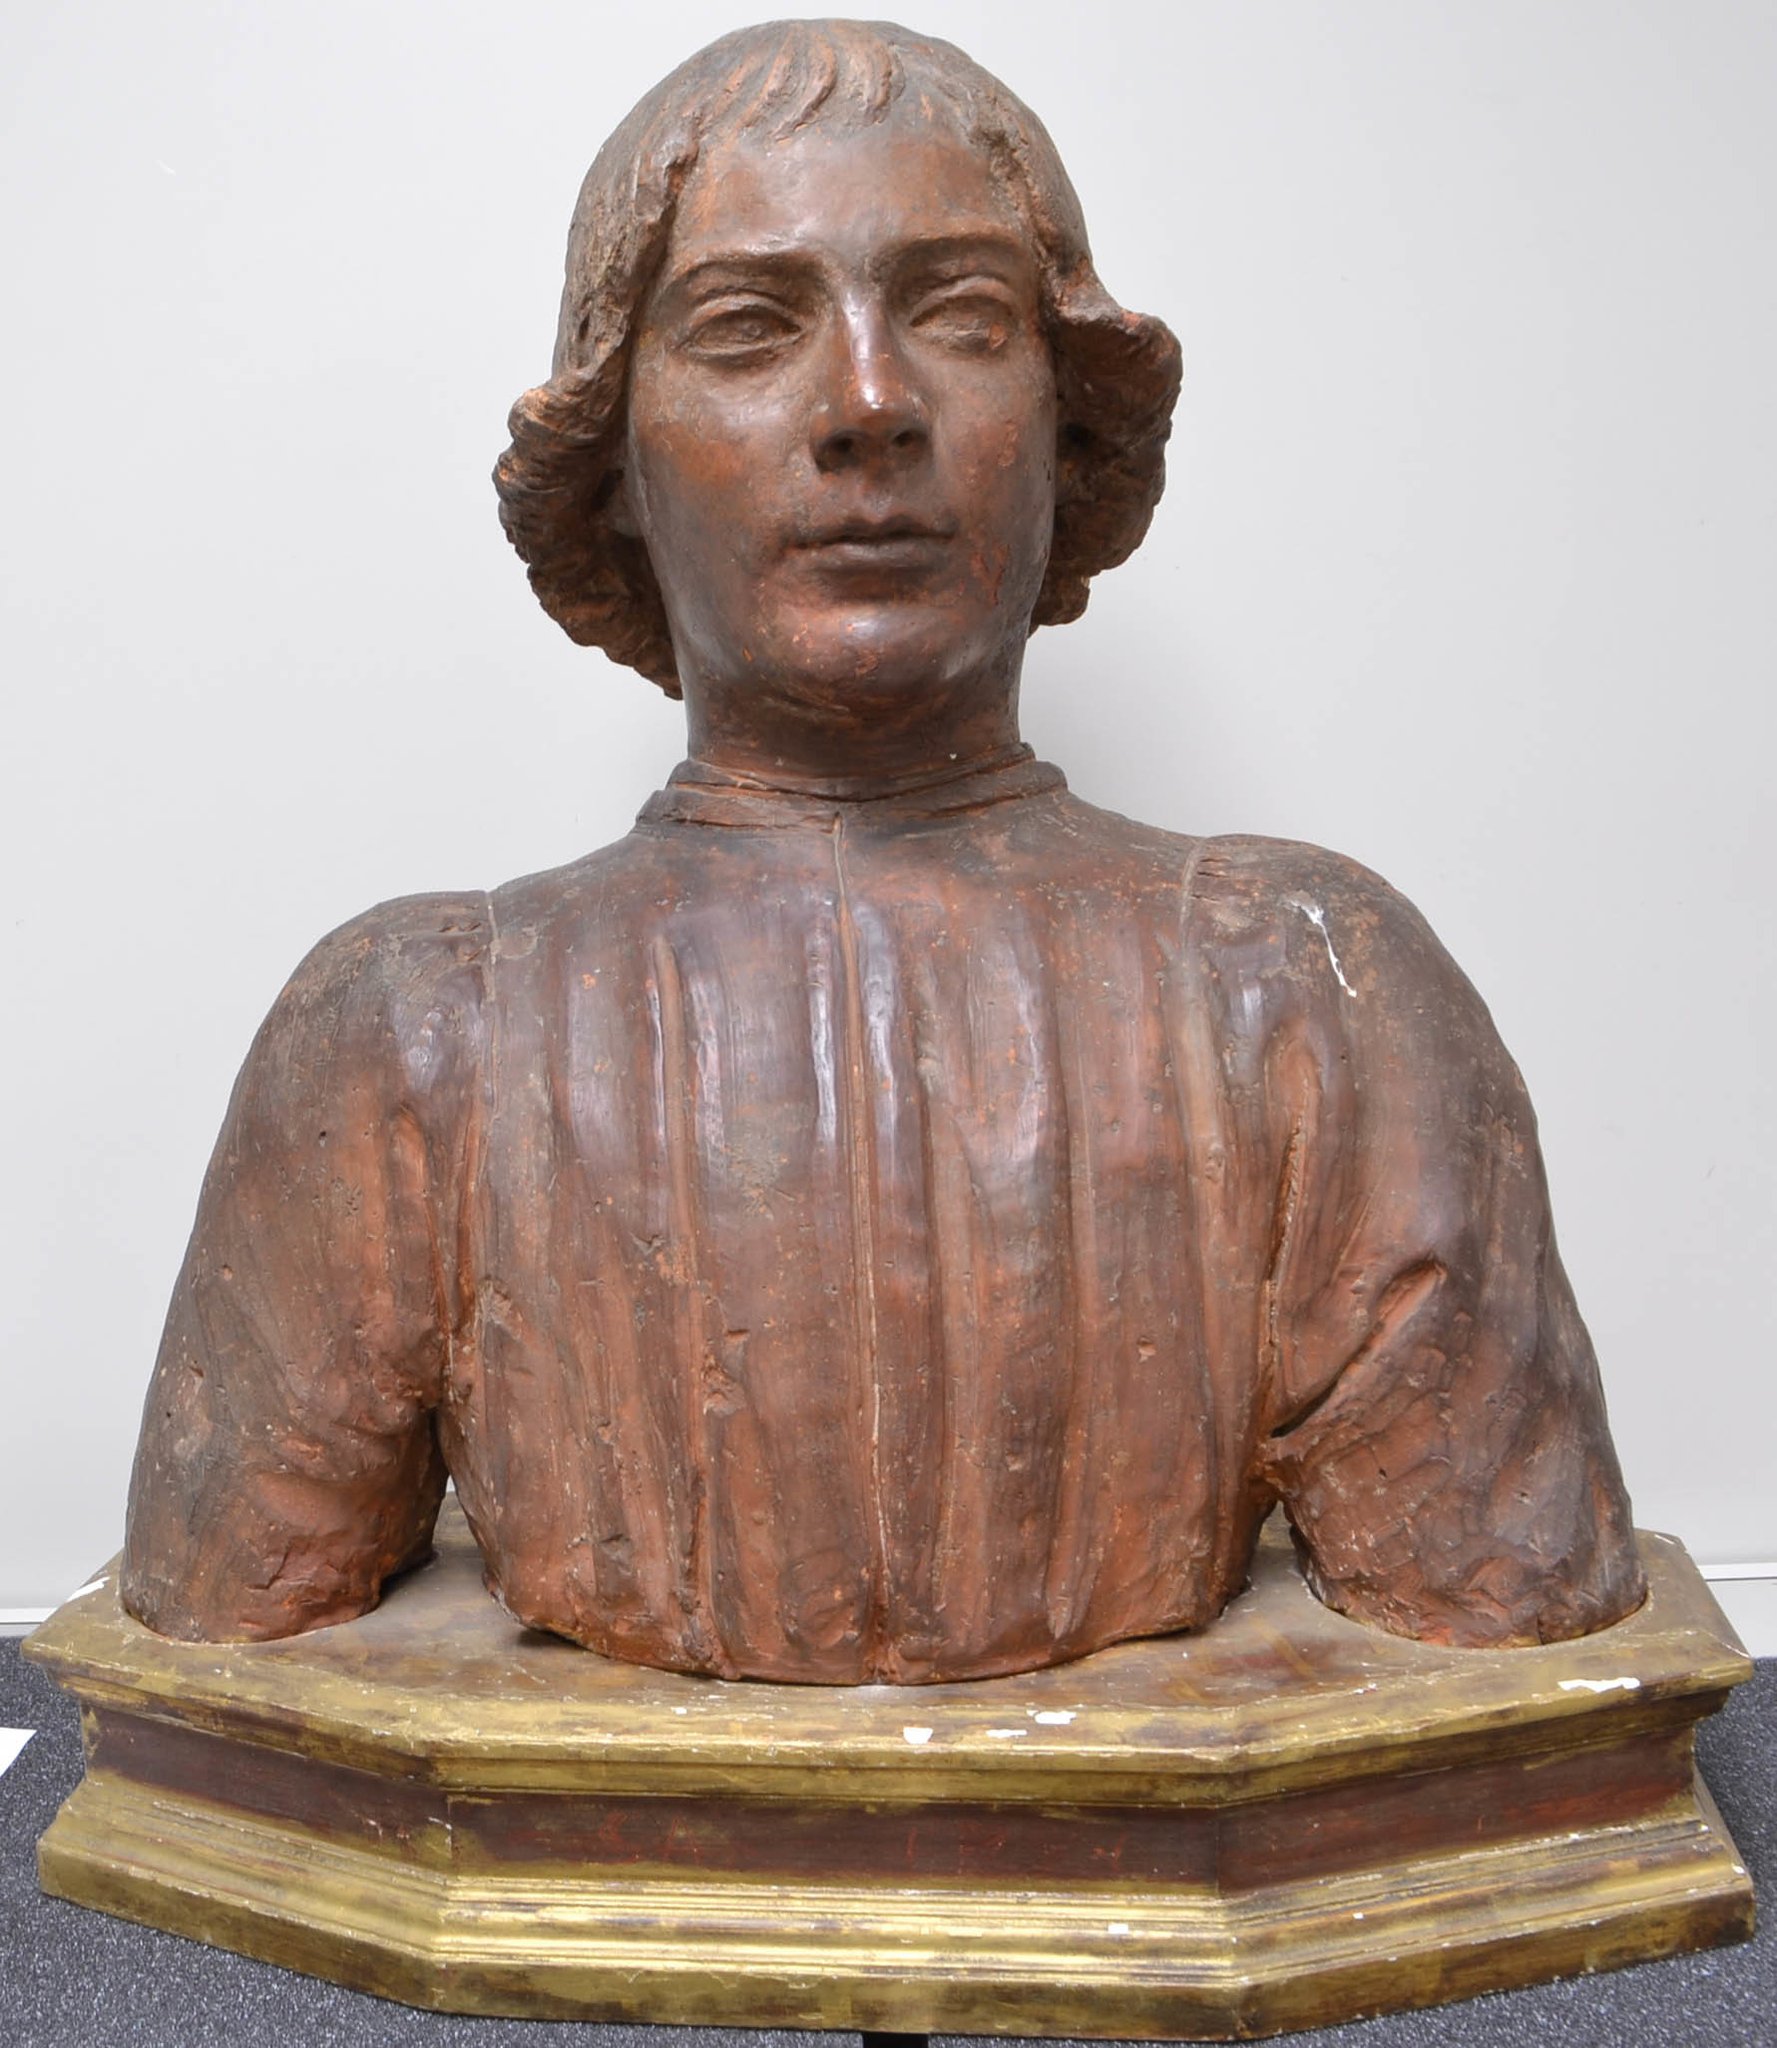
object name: bust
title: Young man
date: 1467-1500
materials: terracotta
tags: men,portraits